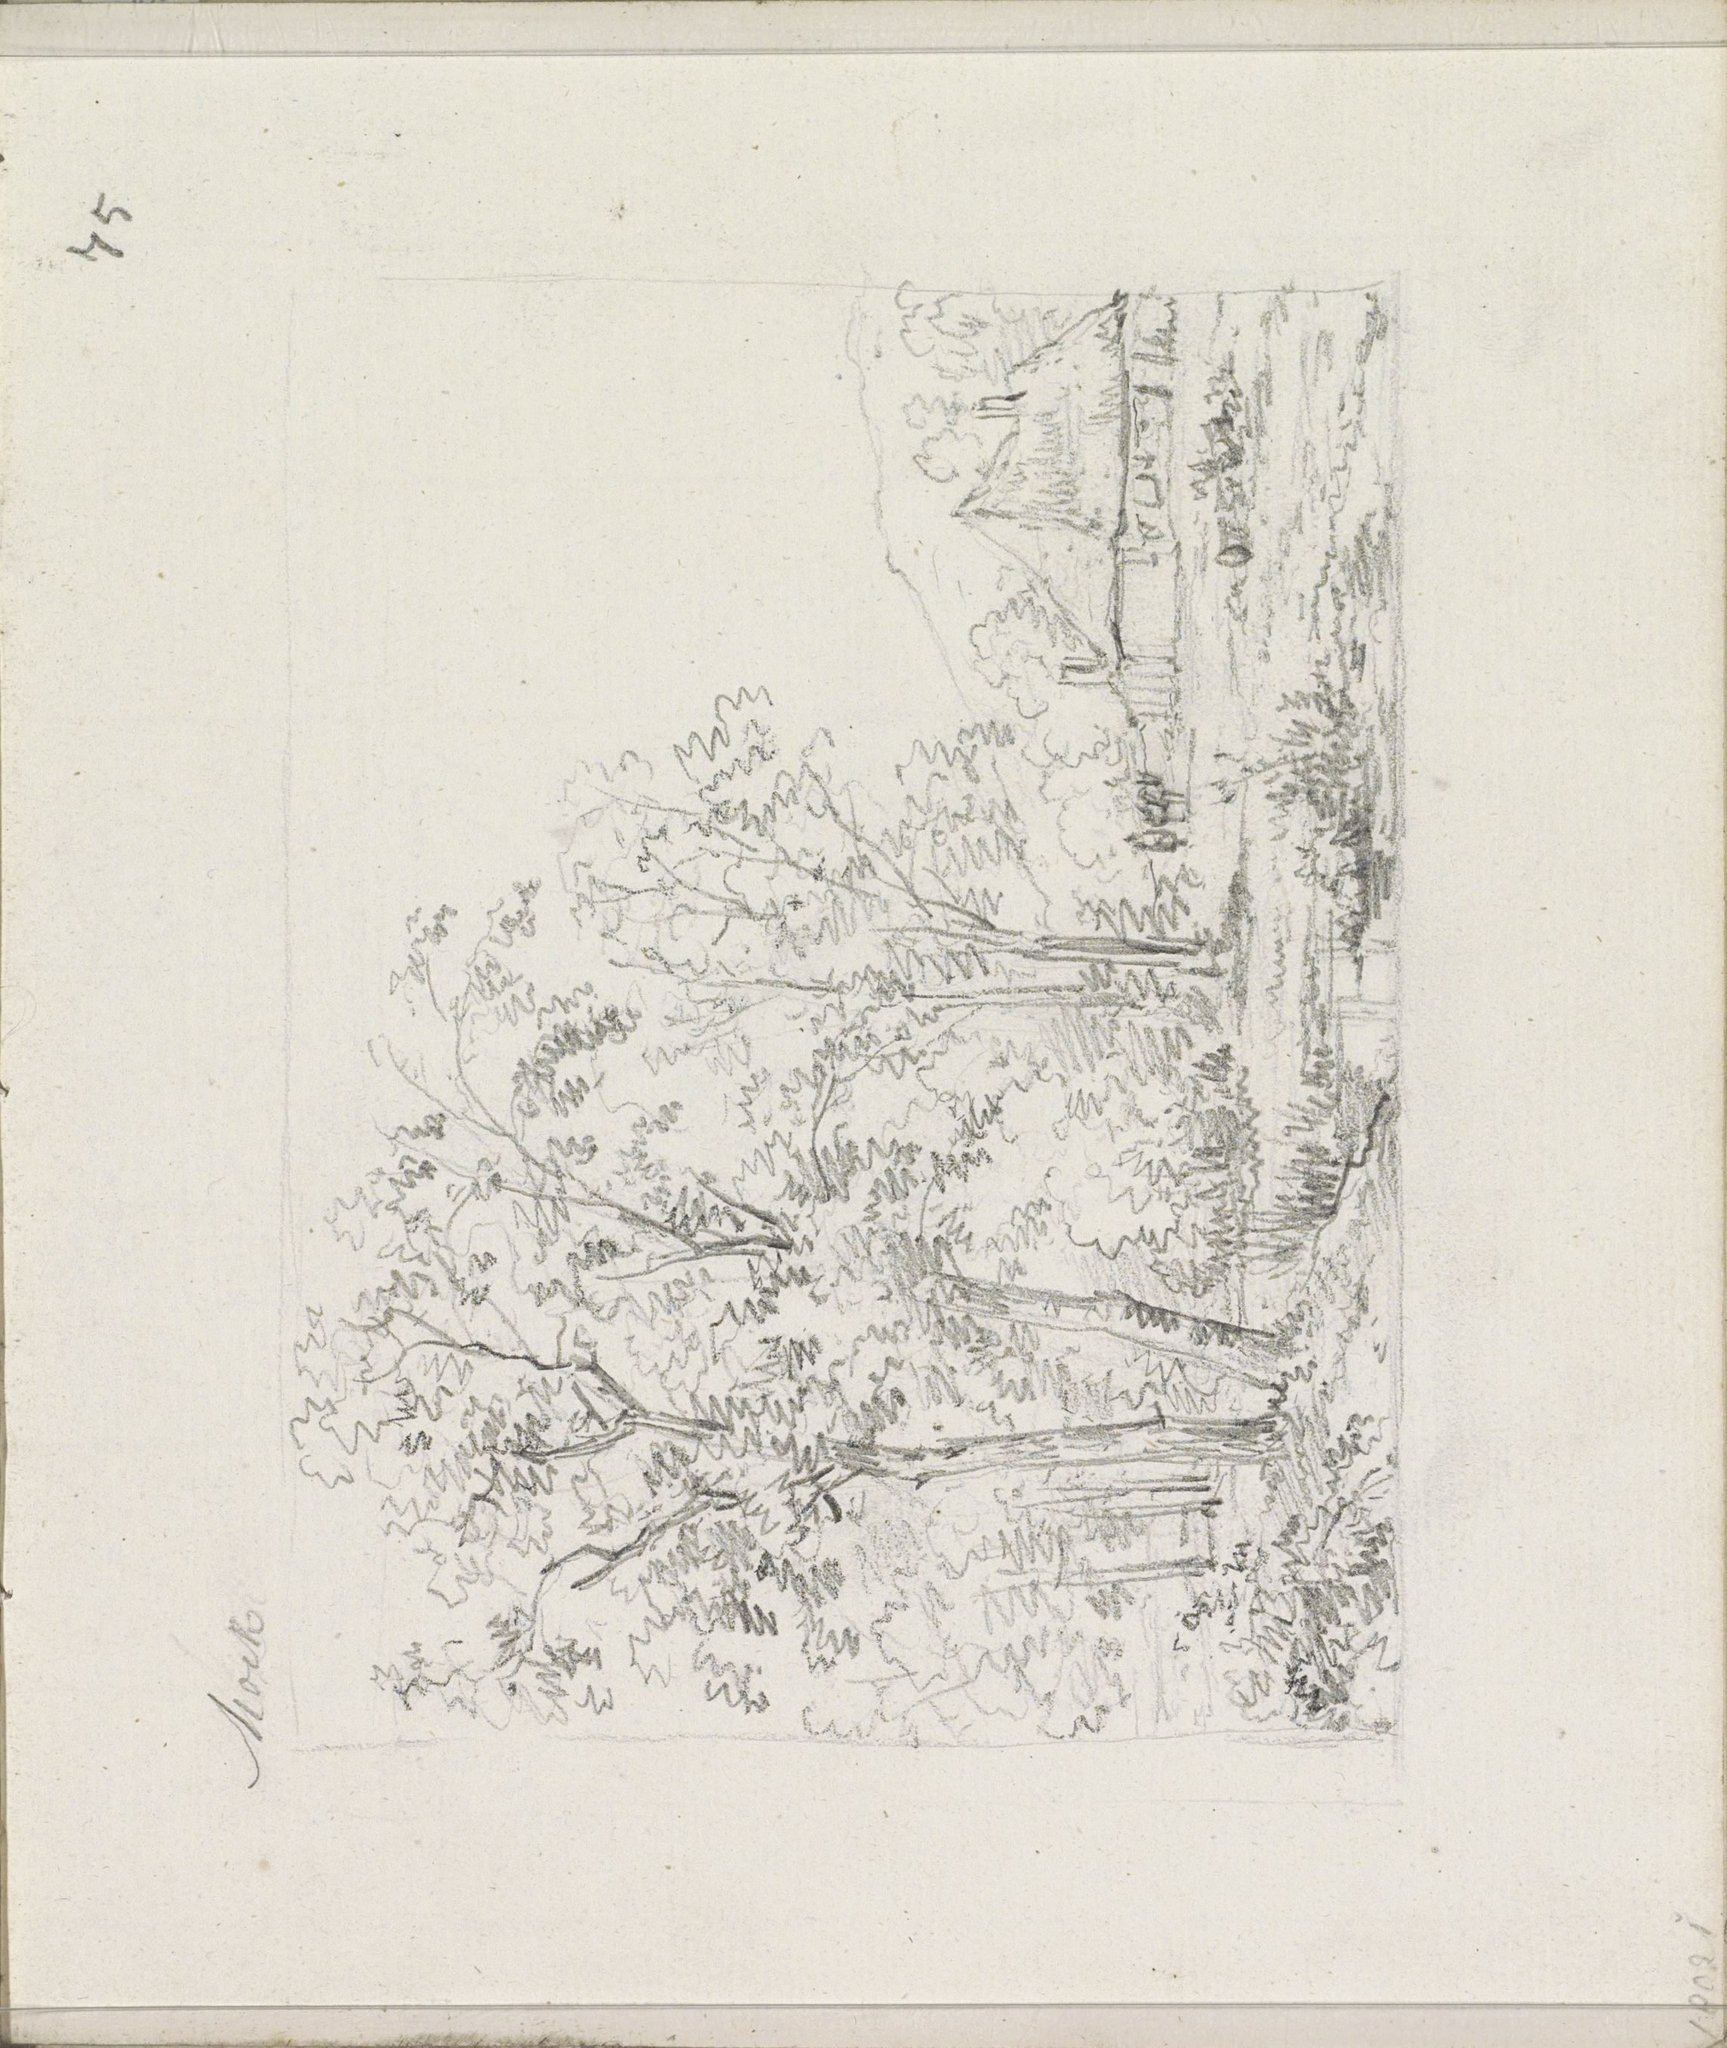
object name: sketchbook leaf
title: Boomrijk landschap met figuren bij een boerderij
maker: andreas schelfhout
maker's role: draughtsman, painter, print maker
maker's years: 1787-1870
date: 1825-1829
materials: paper, pencil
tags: landscapes with waters, waterscapes, seascapes (in the temperate zone) (+ landscape with figures, staffage), farm (building)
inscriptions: annotation: ‘hoek’, number: ‘75/ 18021’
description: Op de voorgrond water. Blad 90 recto uit een schetsboek met 95 bladen.